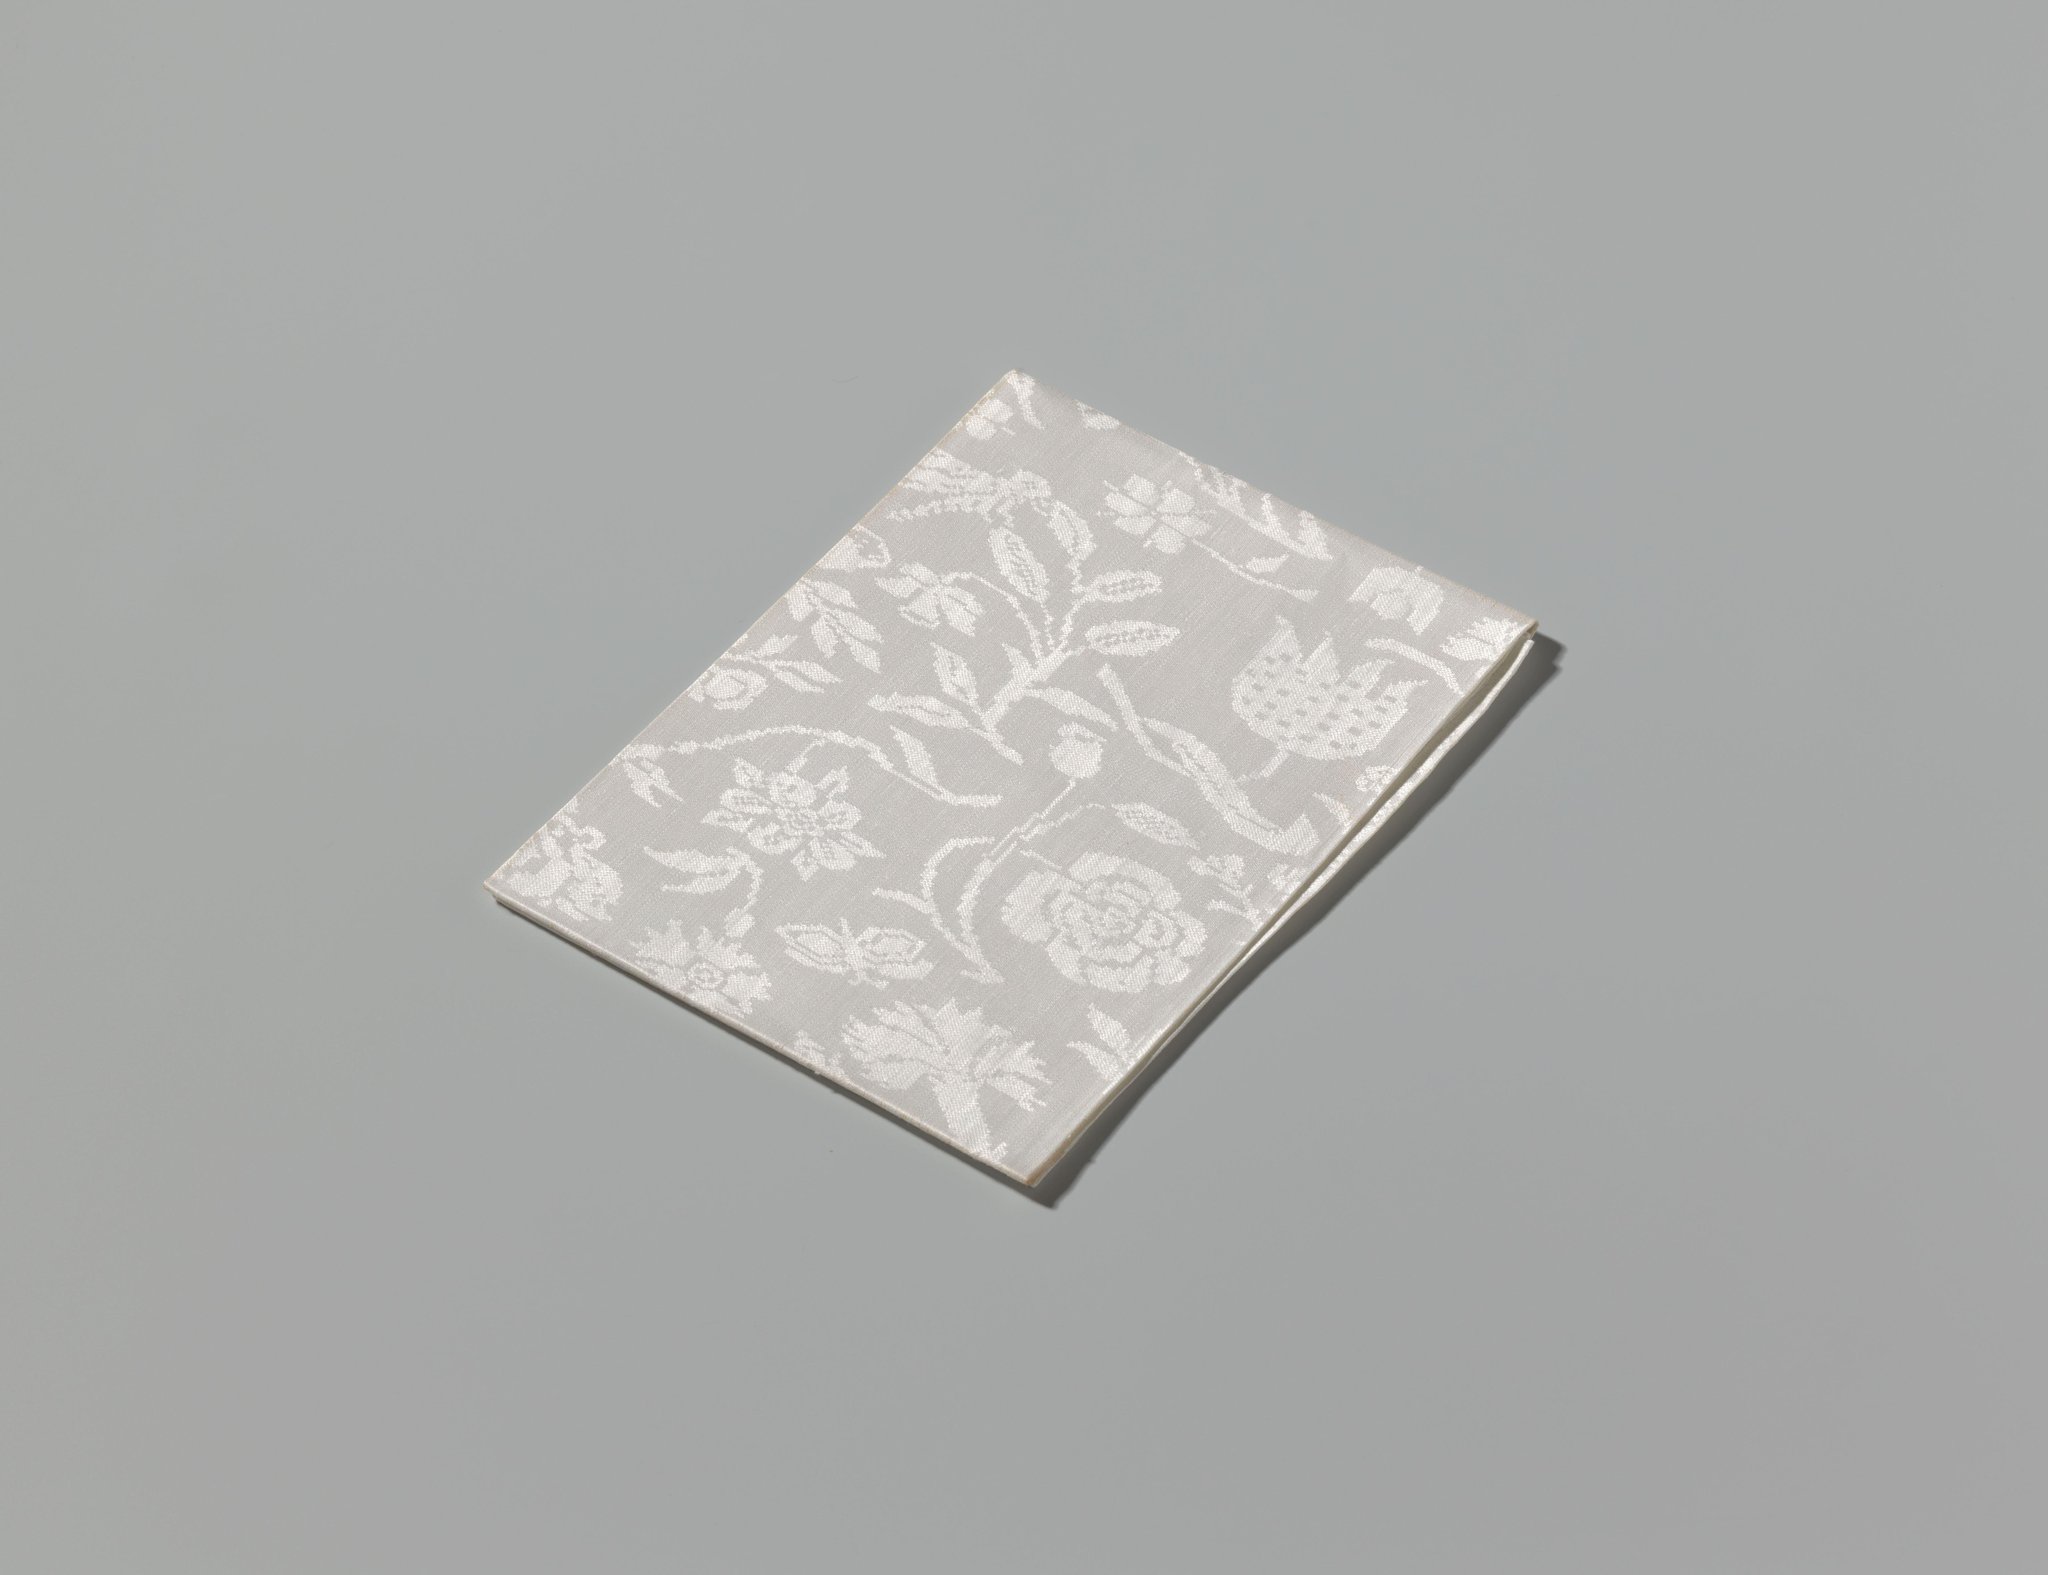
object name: napkin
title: Servet van wit linnendamast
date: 1640-1650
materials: linen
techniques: damask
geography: northern netherlands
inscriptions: : ‘kroon IB 24’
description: Wit linnendamasten servet met patroon van gestrooide bloemen en insecten, merk kroon IB 24.